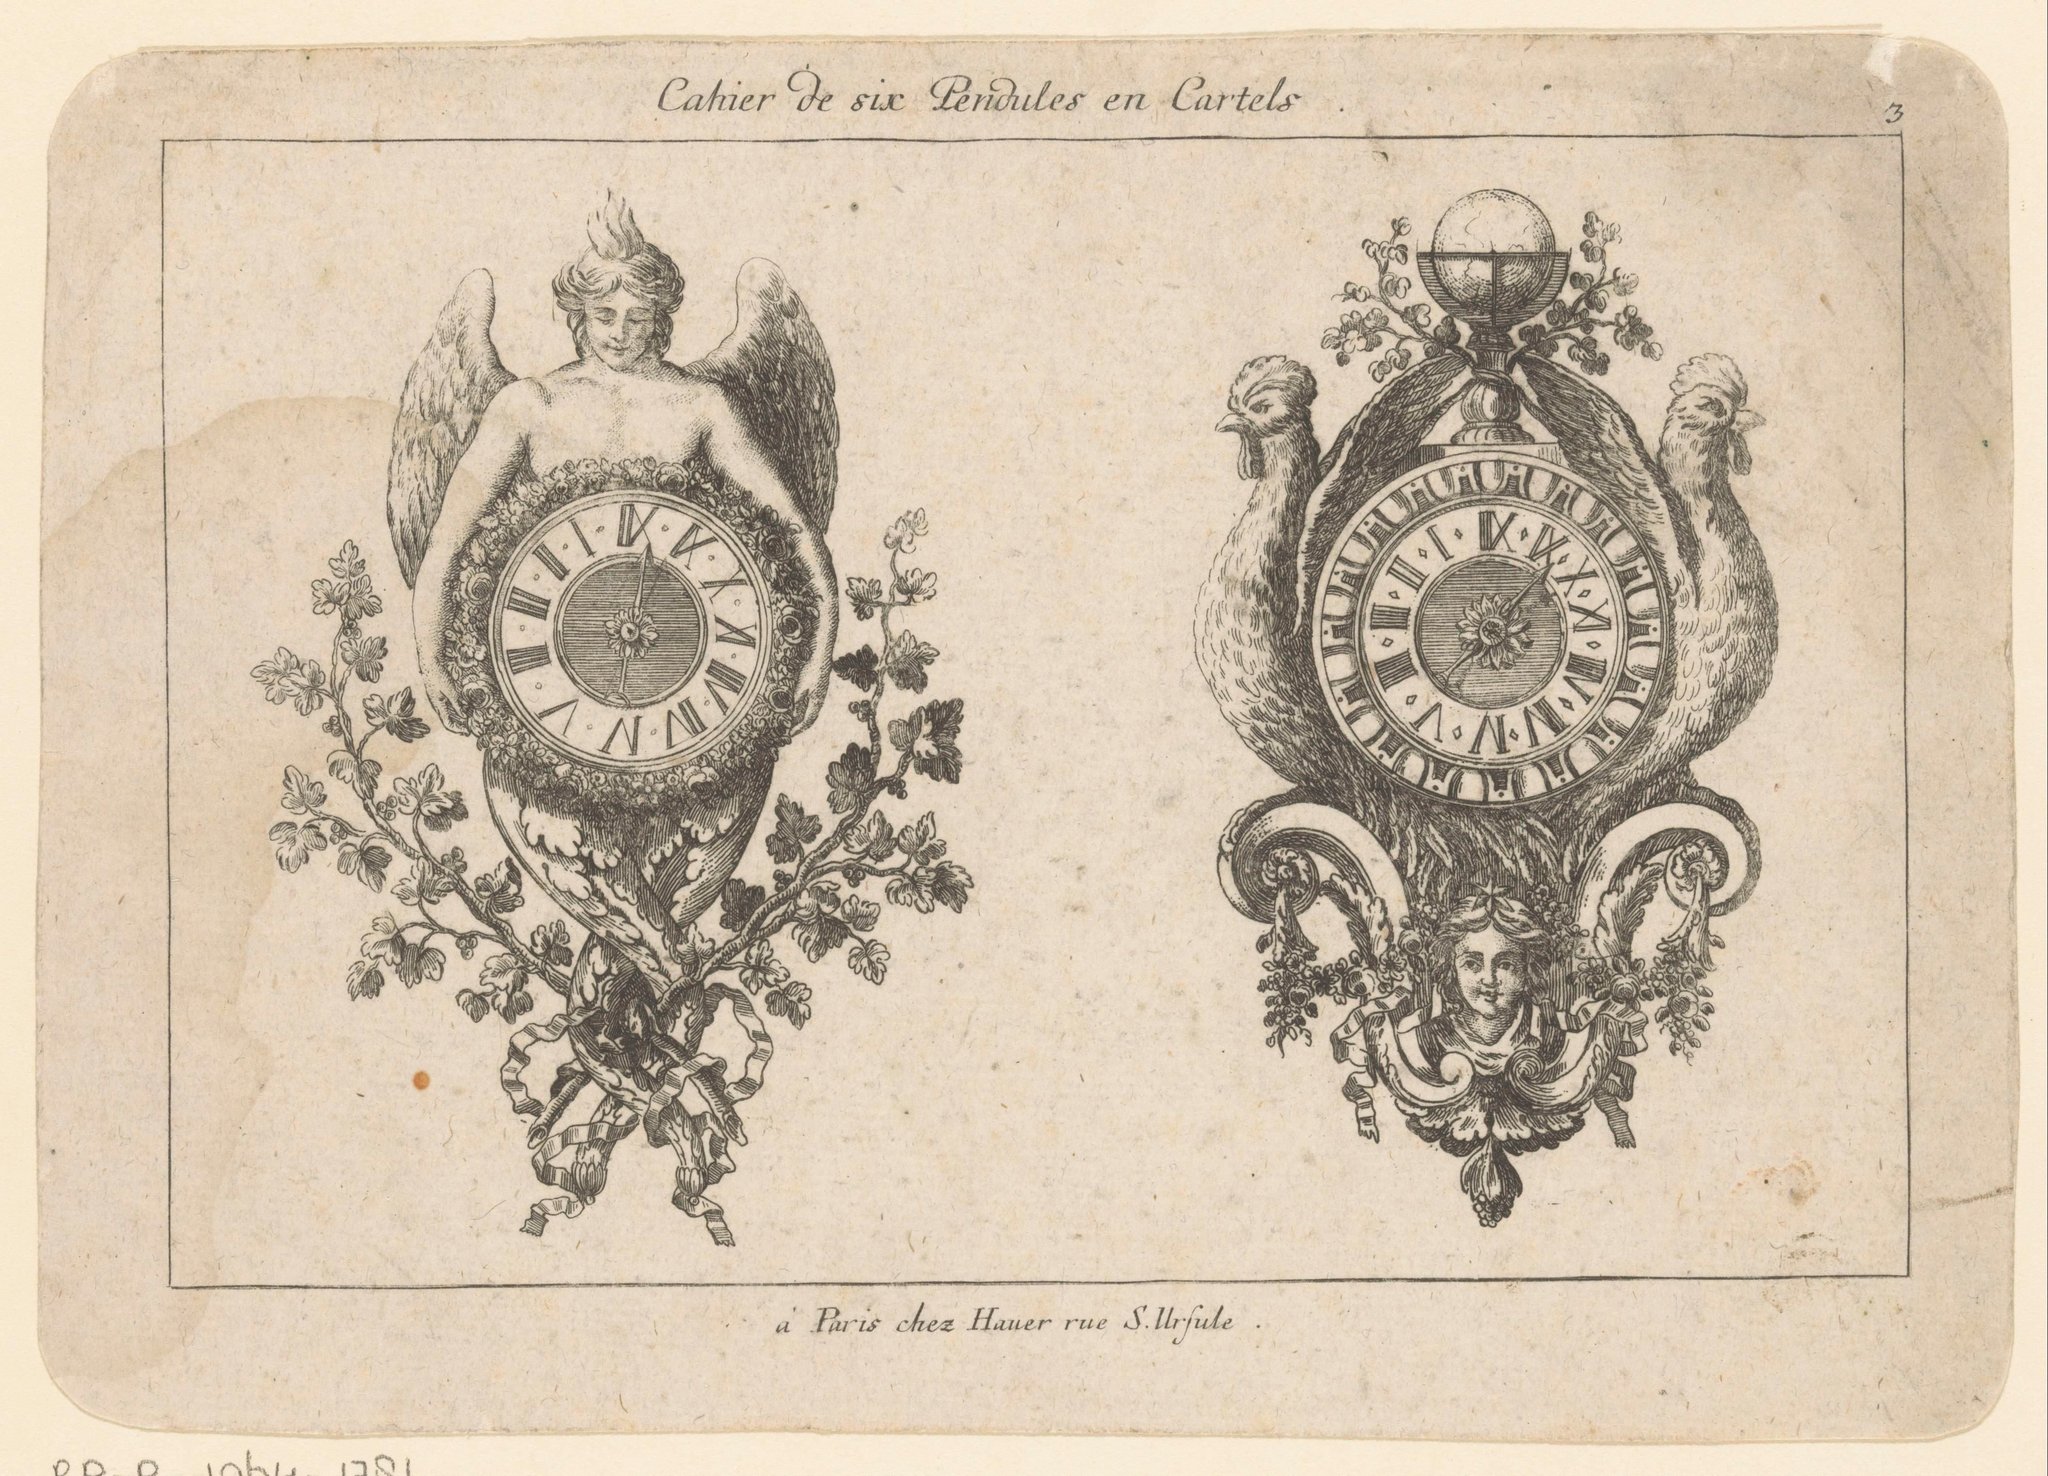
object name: print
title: Twee cartelklokken met gevleugelde figuur en kippen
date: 1758-1820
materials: paper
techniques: engraving, etching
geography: paris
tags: clock, fowl (cock, hen, chicken, etc.), fabulous beings with wings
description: Ontwerpen voor twee cartelklokken. De klok links wordt gedragen door een gevleugelde figuur wiens benen in bladeren overlopen. Twee kippen flankeren de rechterklok.